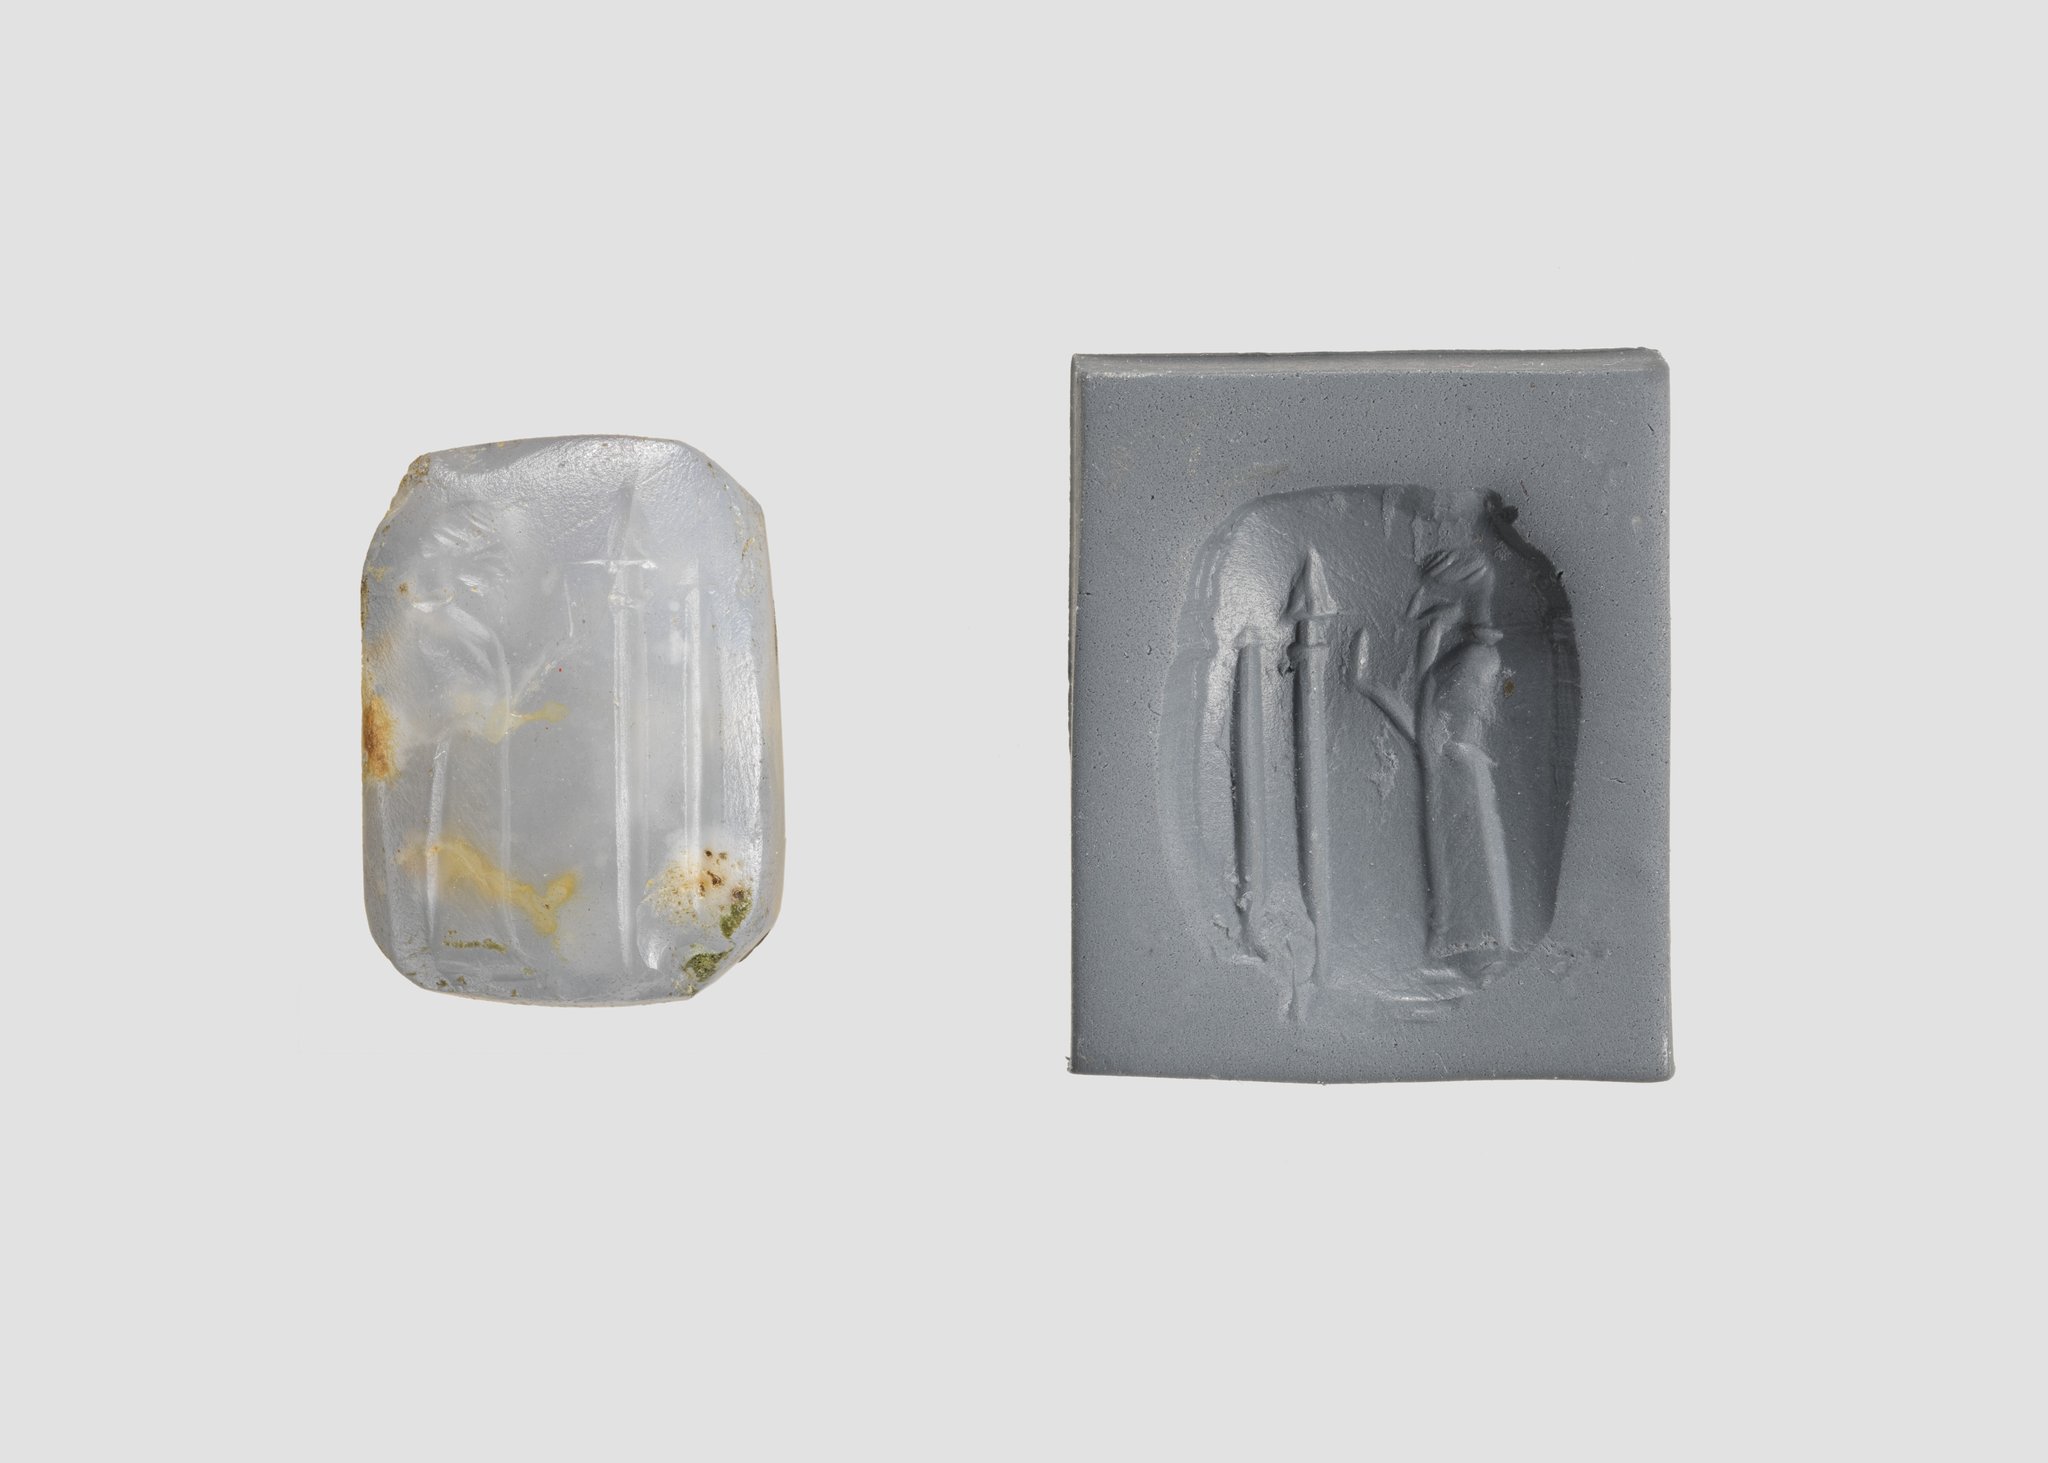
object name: stamp seal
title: Stamp seal (octagonal pyramid) with cultic scene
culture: assyro-babylonian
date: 734-501 BCE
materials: stone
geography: mesopotamia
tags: men